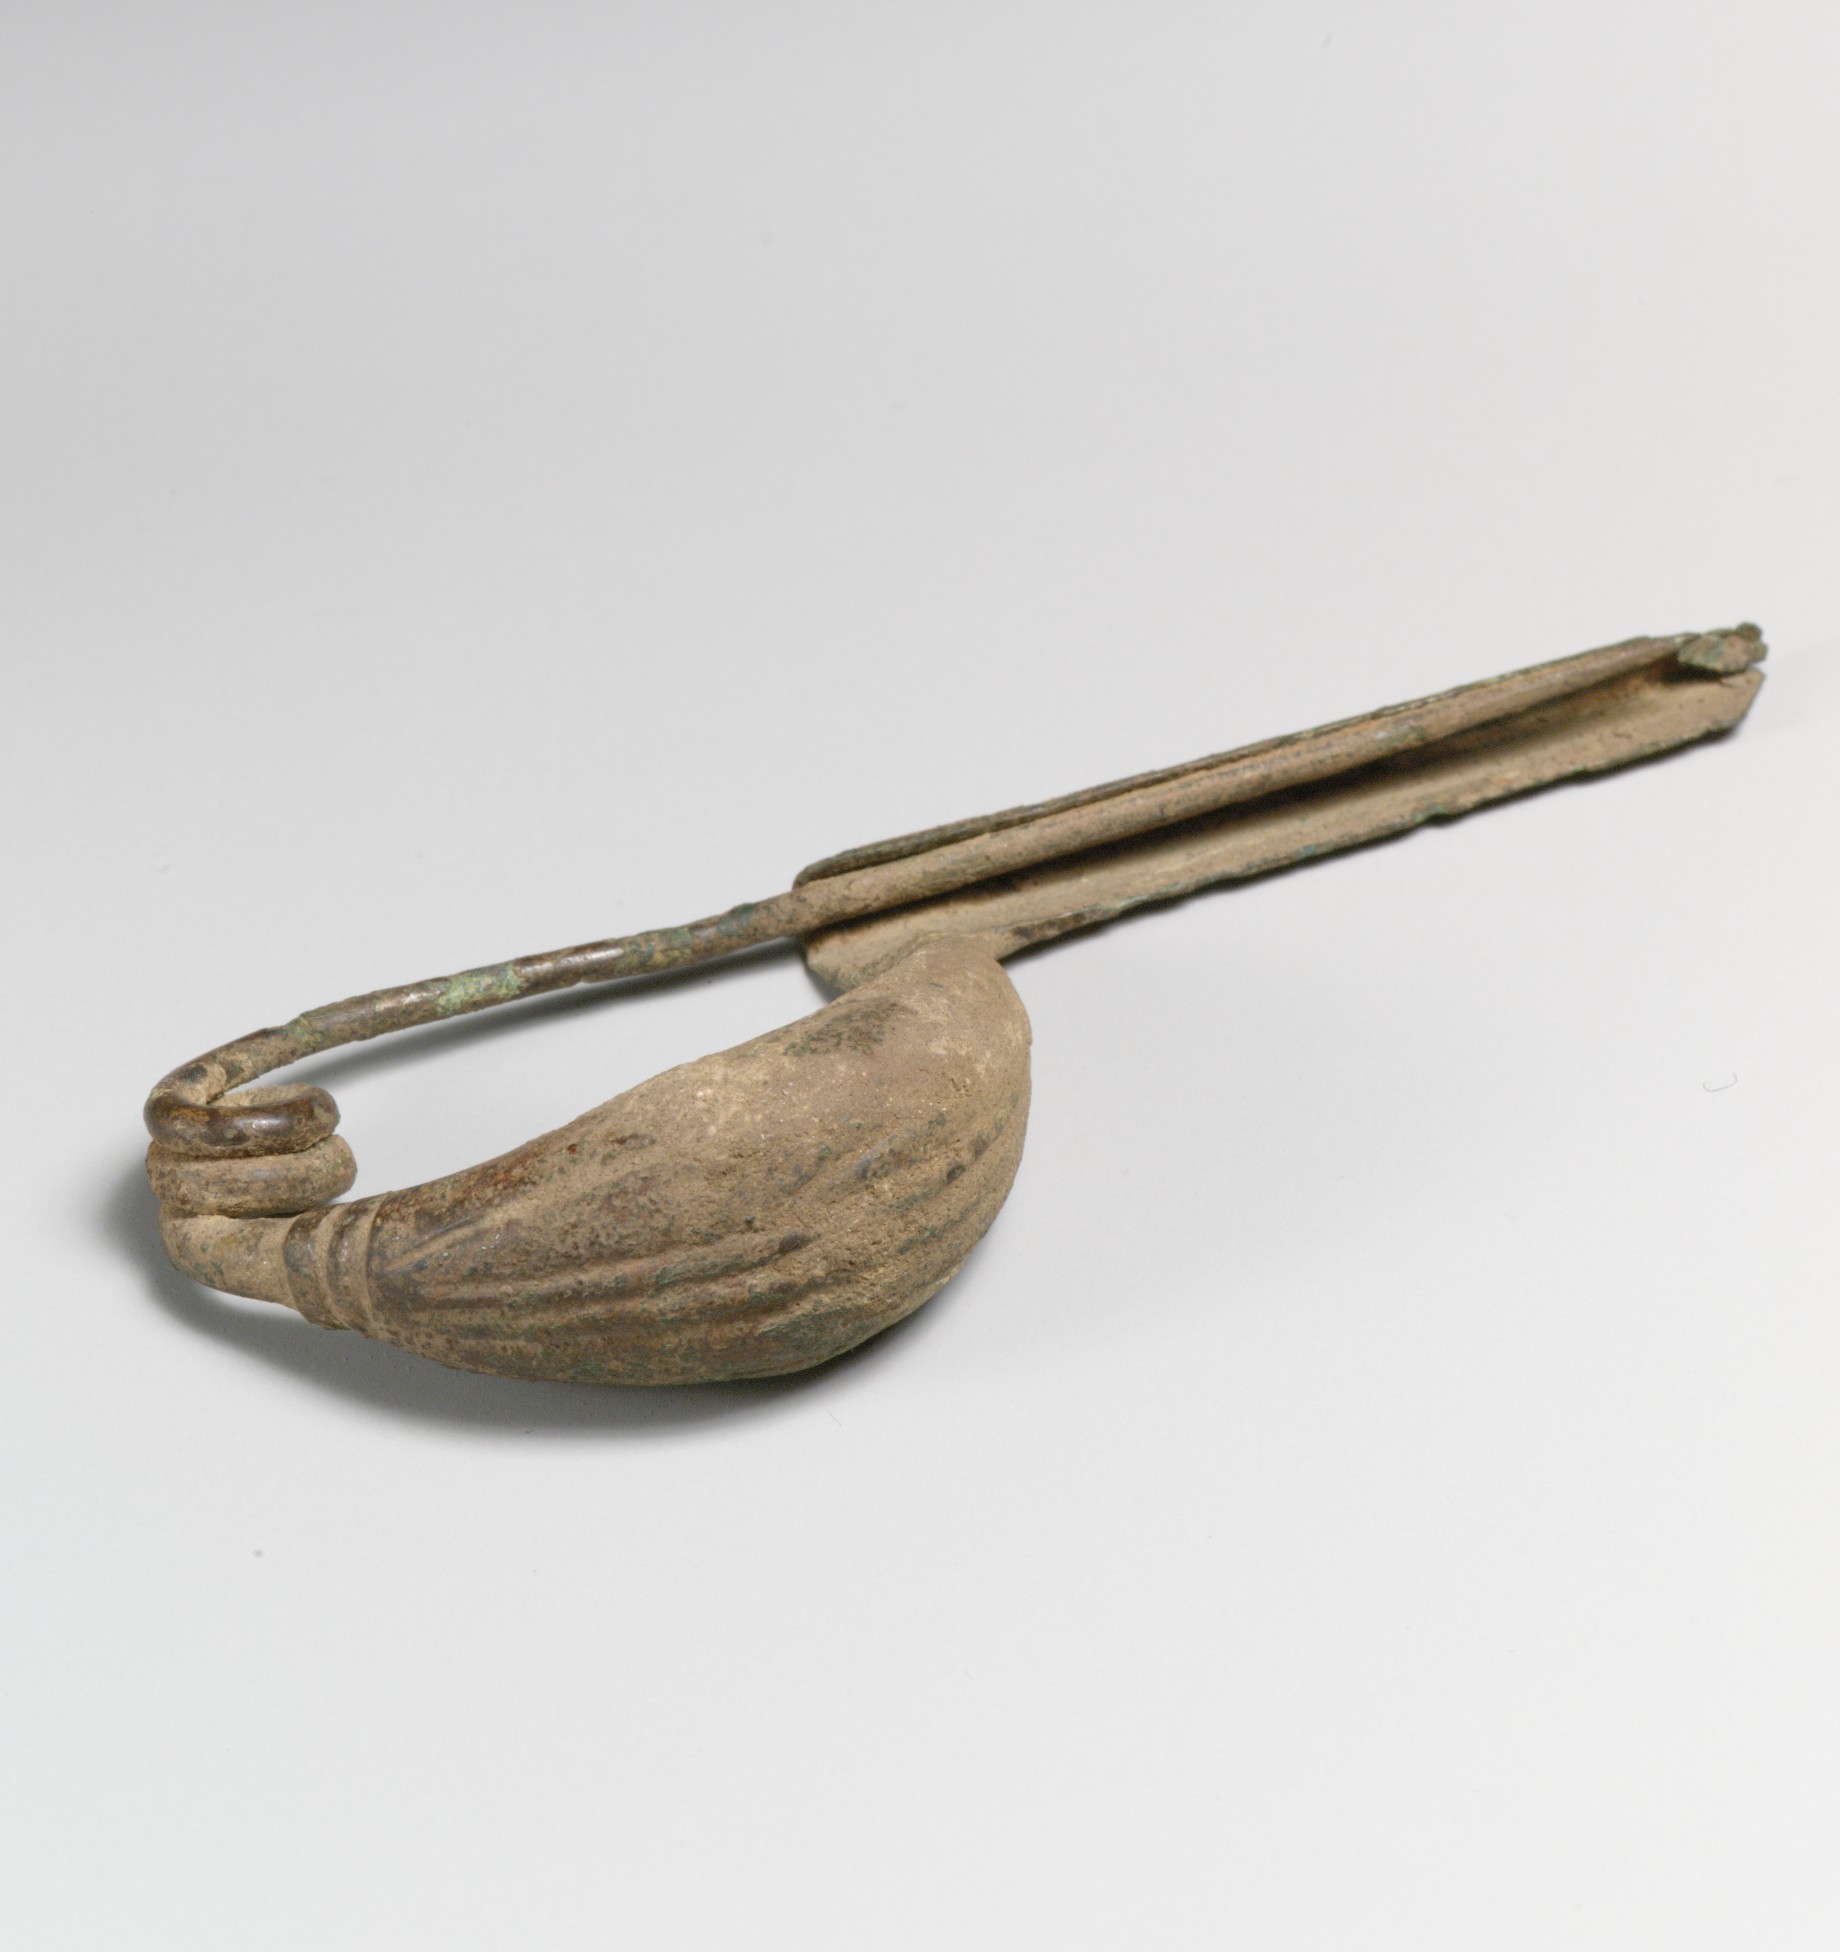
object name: fibula, boat shaped type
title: Fibula, boat-shaped type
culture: italic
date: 800-501 BCE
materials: bronze